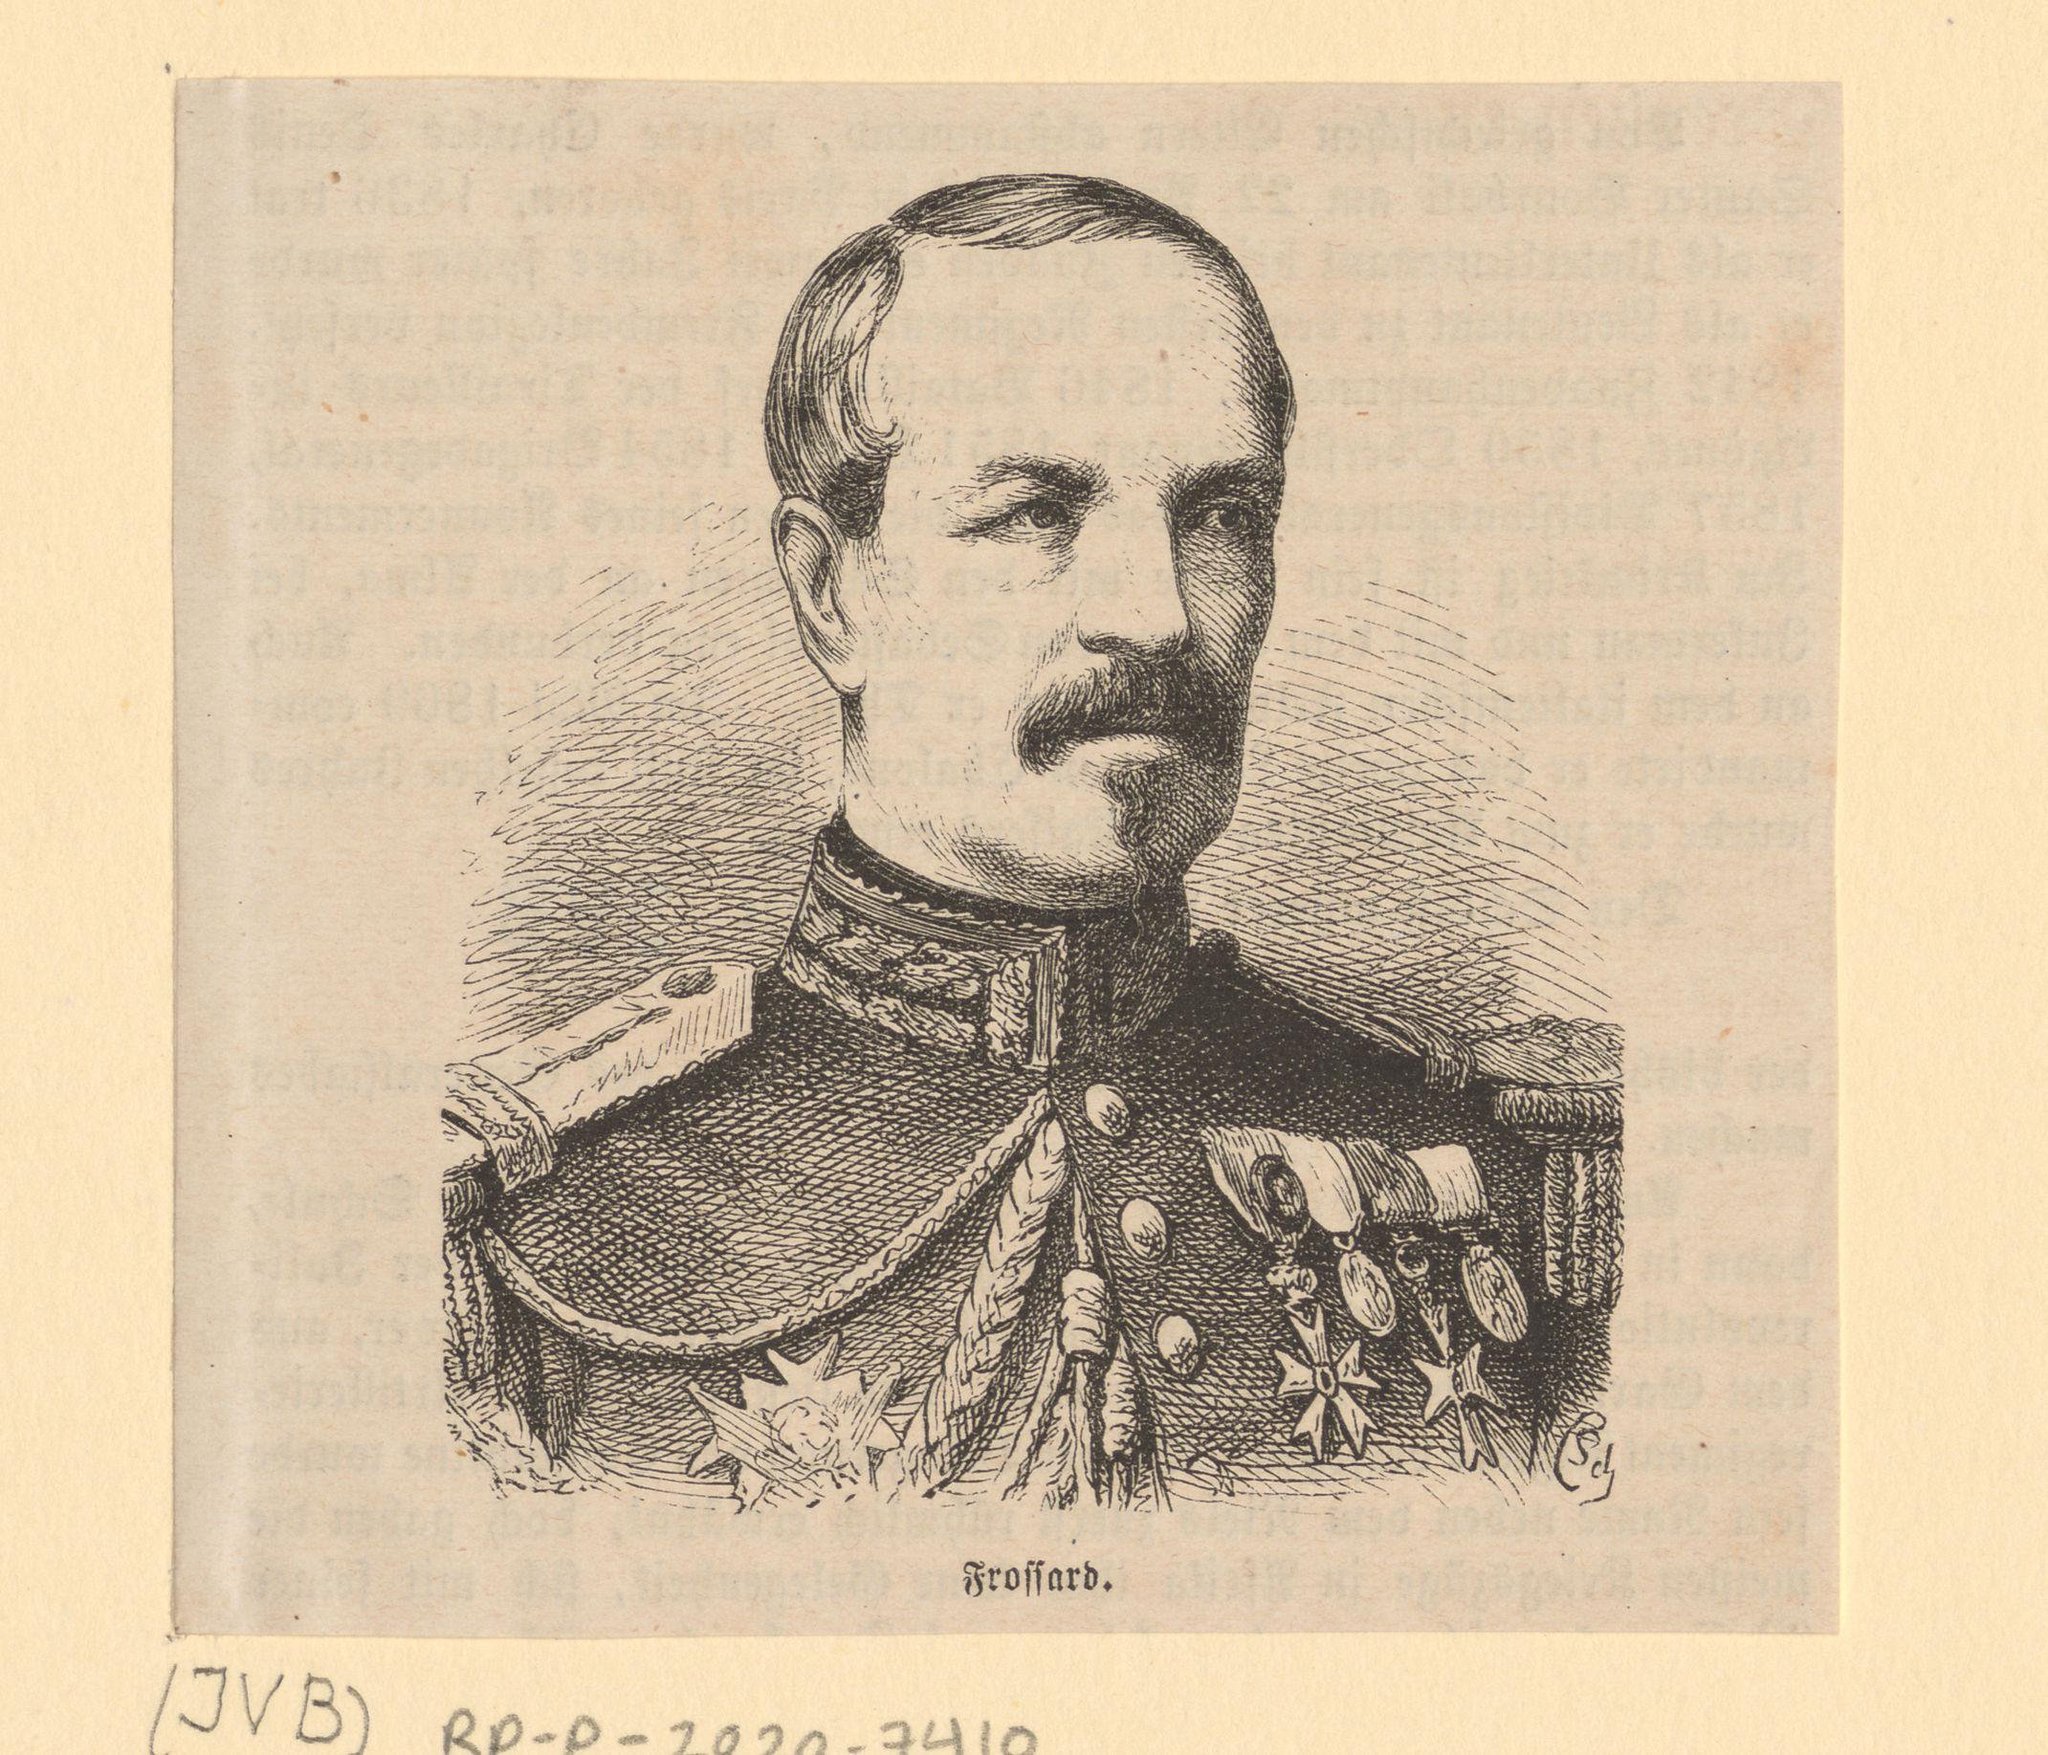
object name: print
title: Portret van Charles Auguste Frossard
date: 1870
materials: paper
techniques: letterpress printing, engraving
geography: leipzig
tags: commander-in-chief, general, marshal, historical persons, (military) uniforms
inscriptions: stamp: ‘JVB’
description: Prent uit: Daheim: ein Deutsches Familienblatt mit Illustrationen 6 (1870), nr. 47, 20 augustus 1870, p. 745.